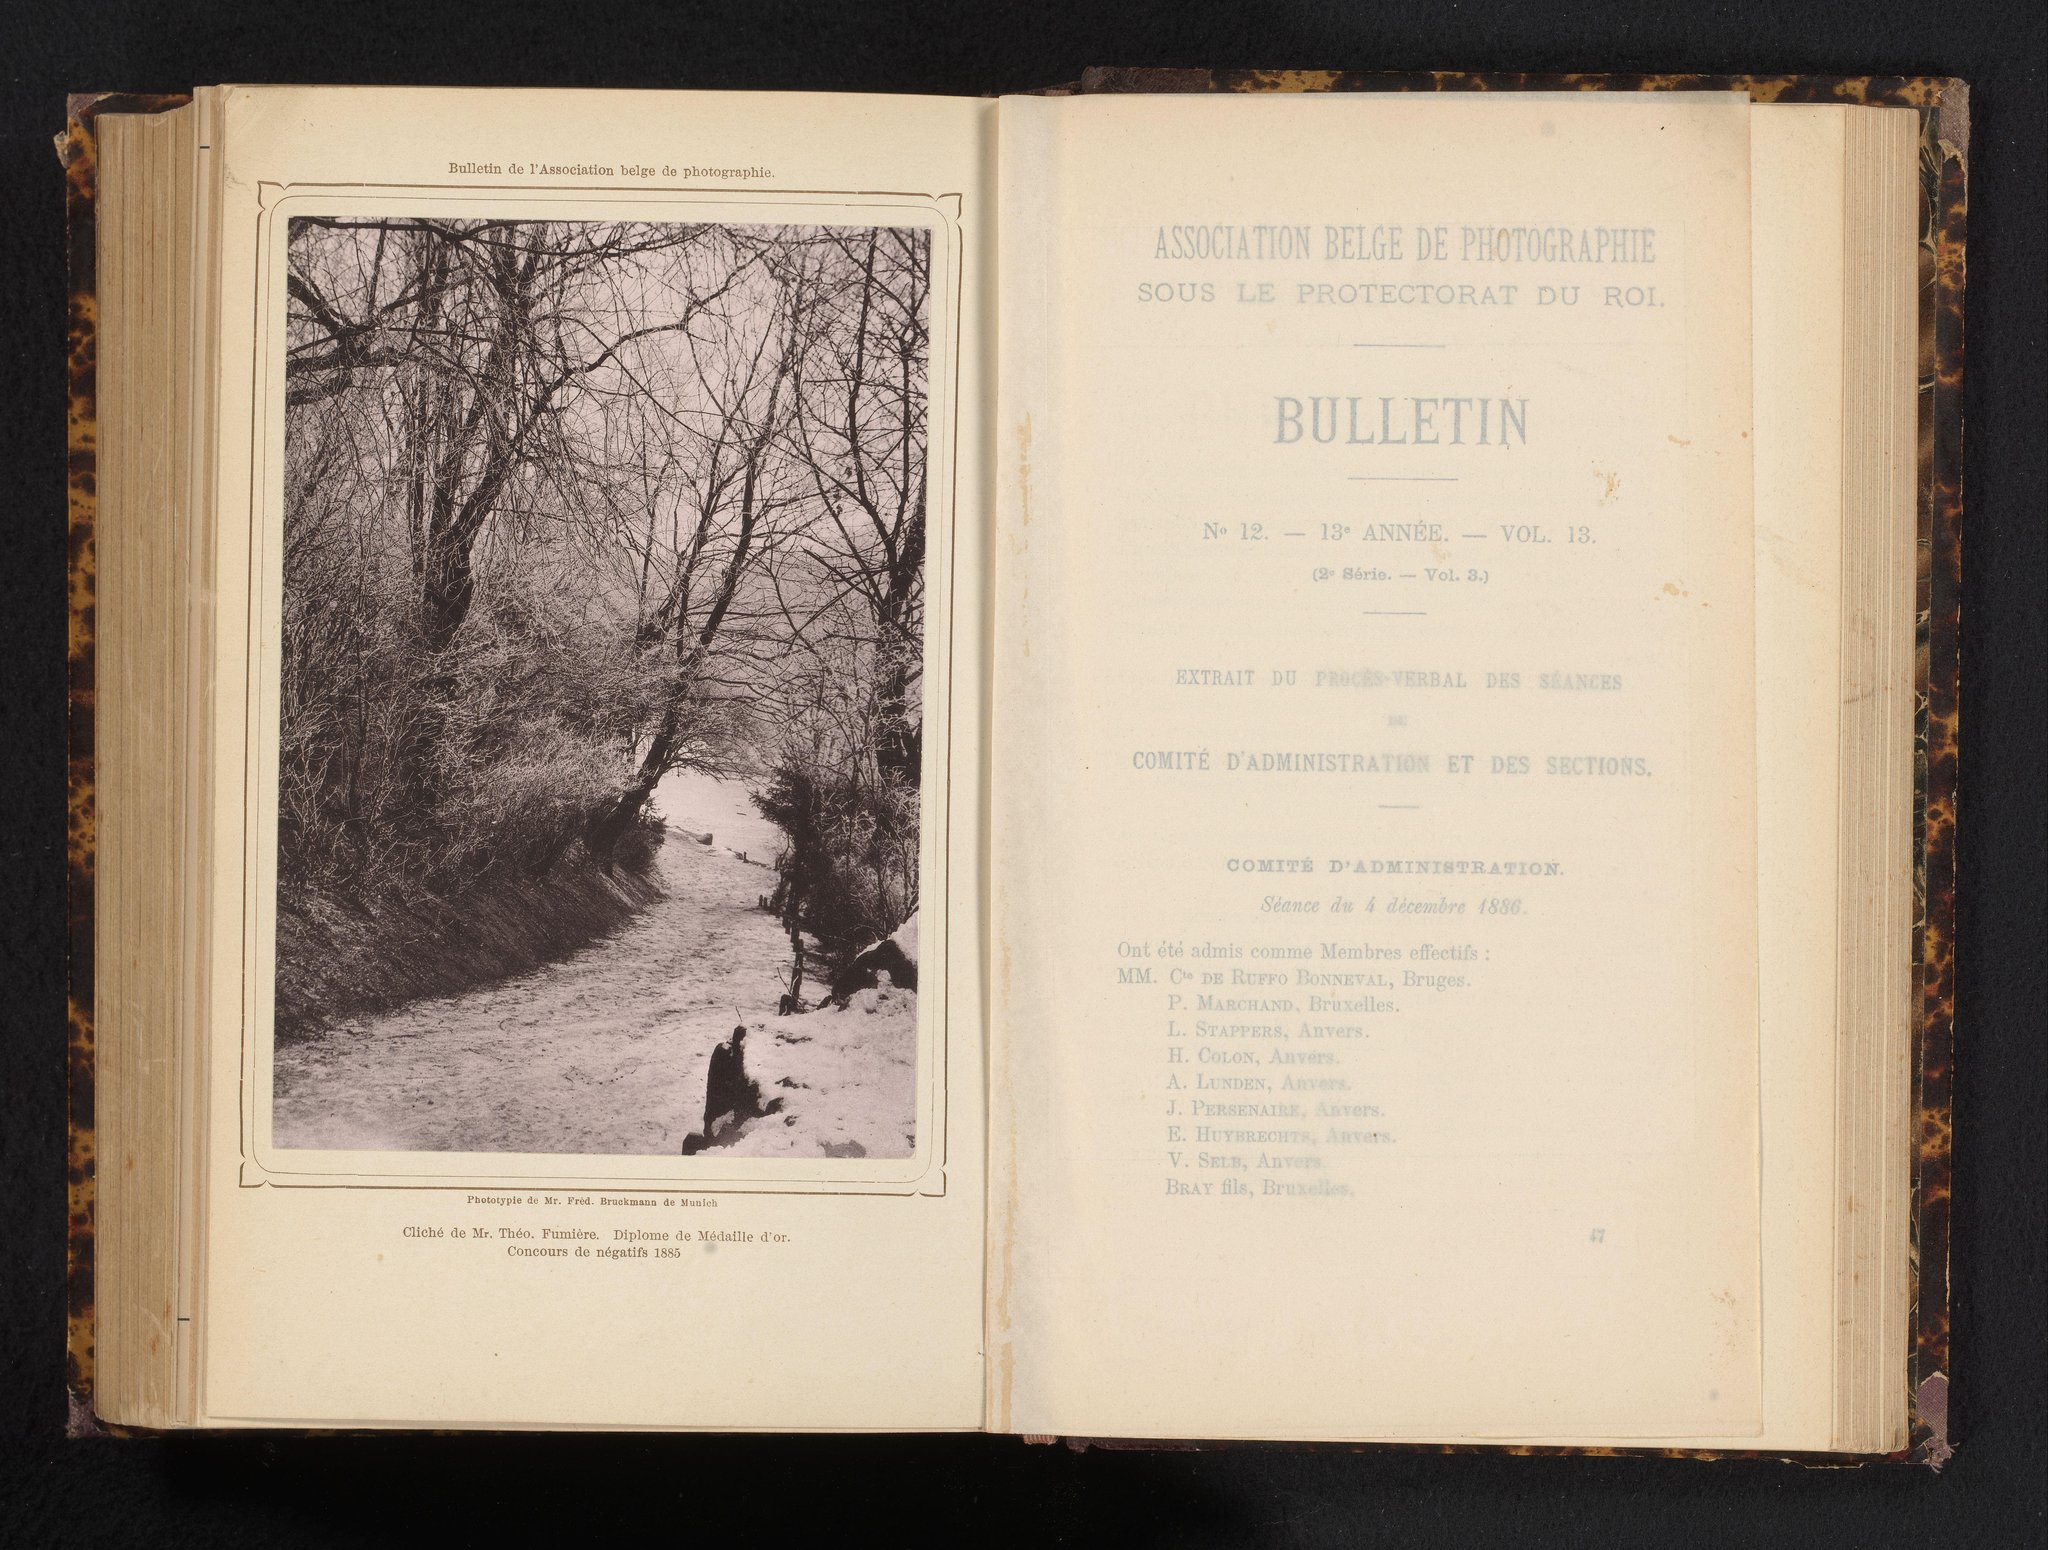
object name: page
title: Park in Antwerpen in de sneeuw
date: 1880-1885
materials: cardboard, paper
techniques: photograph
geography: munich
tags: park, snow, public gardens, park, antwerp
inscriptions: inscription: ‘Diplome de Médaille d'or./ Concours de négatifs 1885’